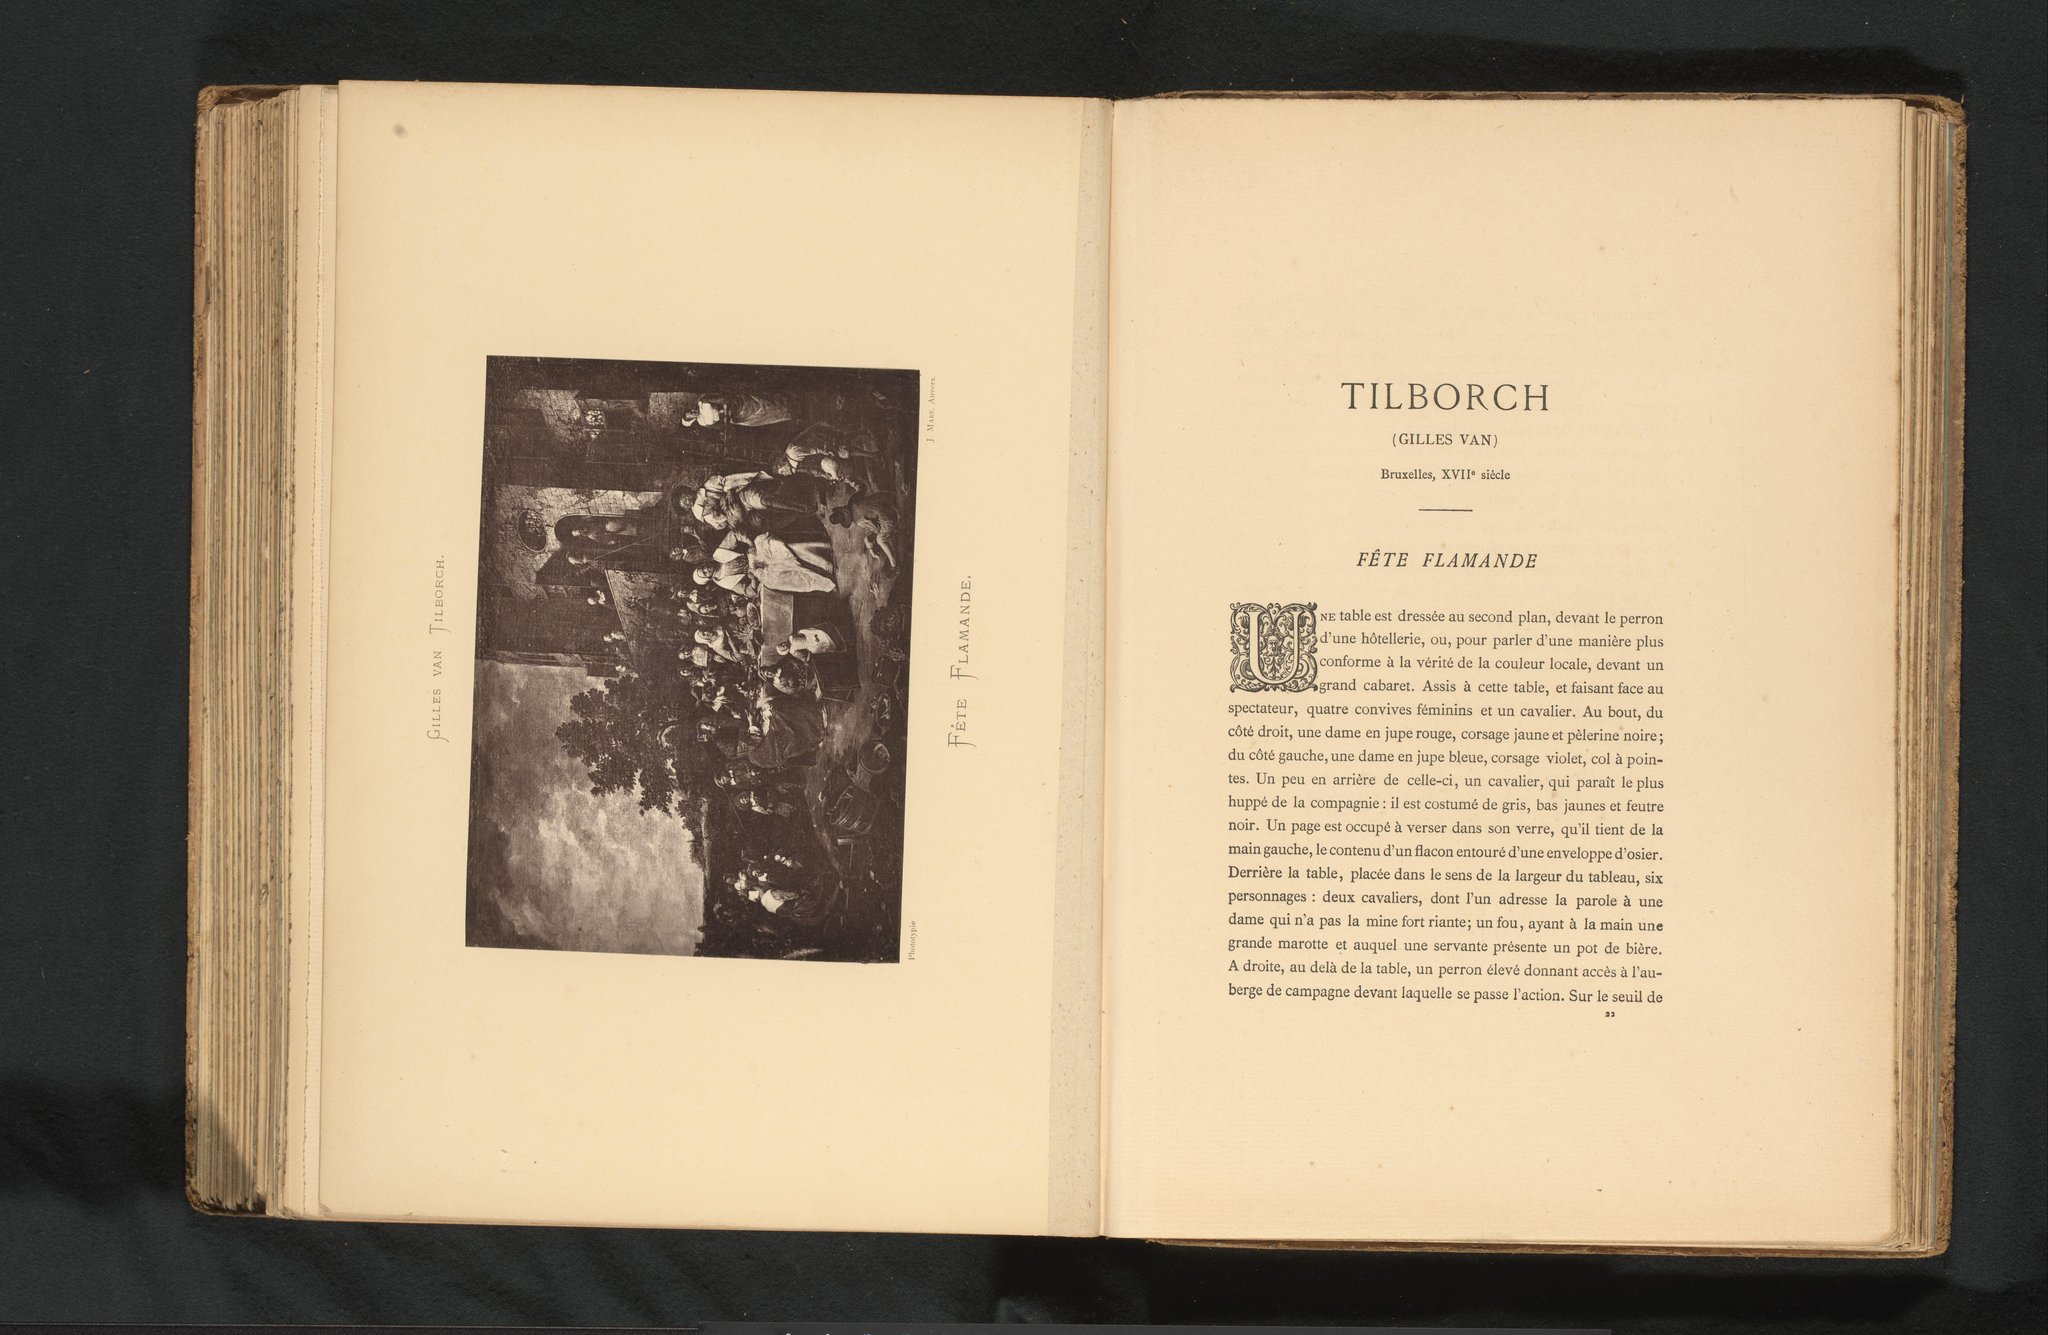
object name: page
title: Reproductie van een schilderij van een Vlaams feest door Gilles van Tilborgh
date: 1873-1878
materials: paper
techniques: woodburytype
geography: antwerp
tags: public festivities, celebration meal, feast, banquet - cc - out of doors